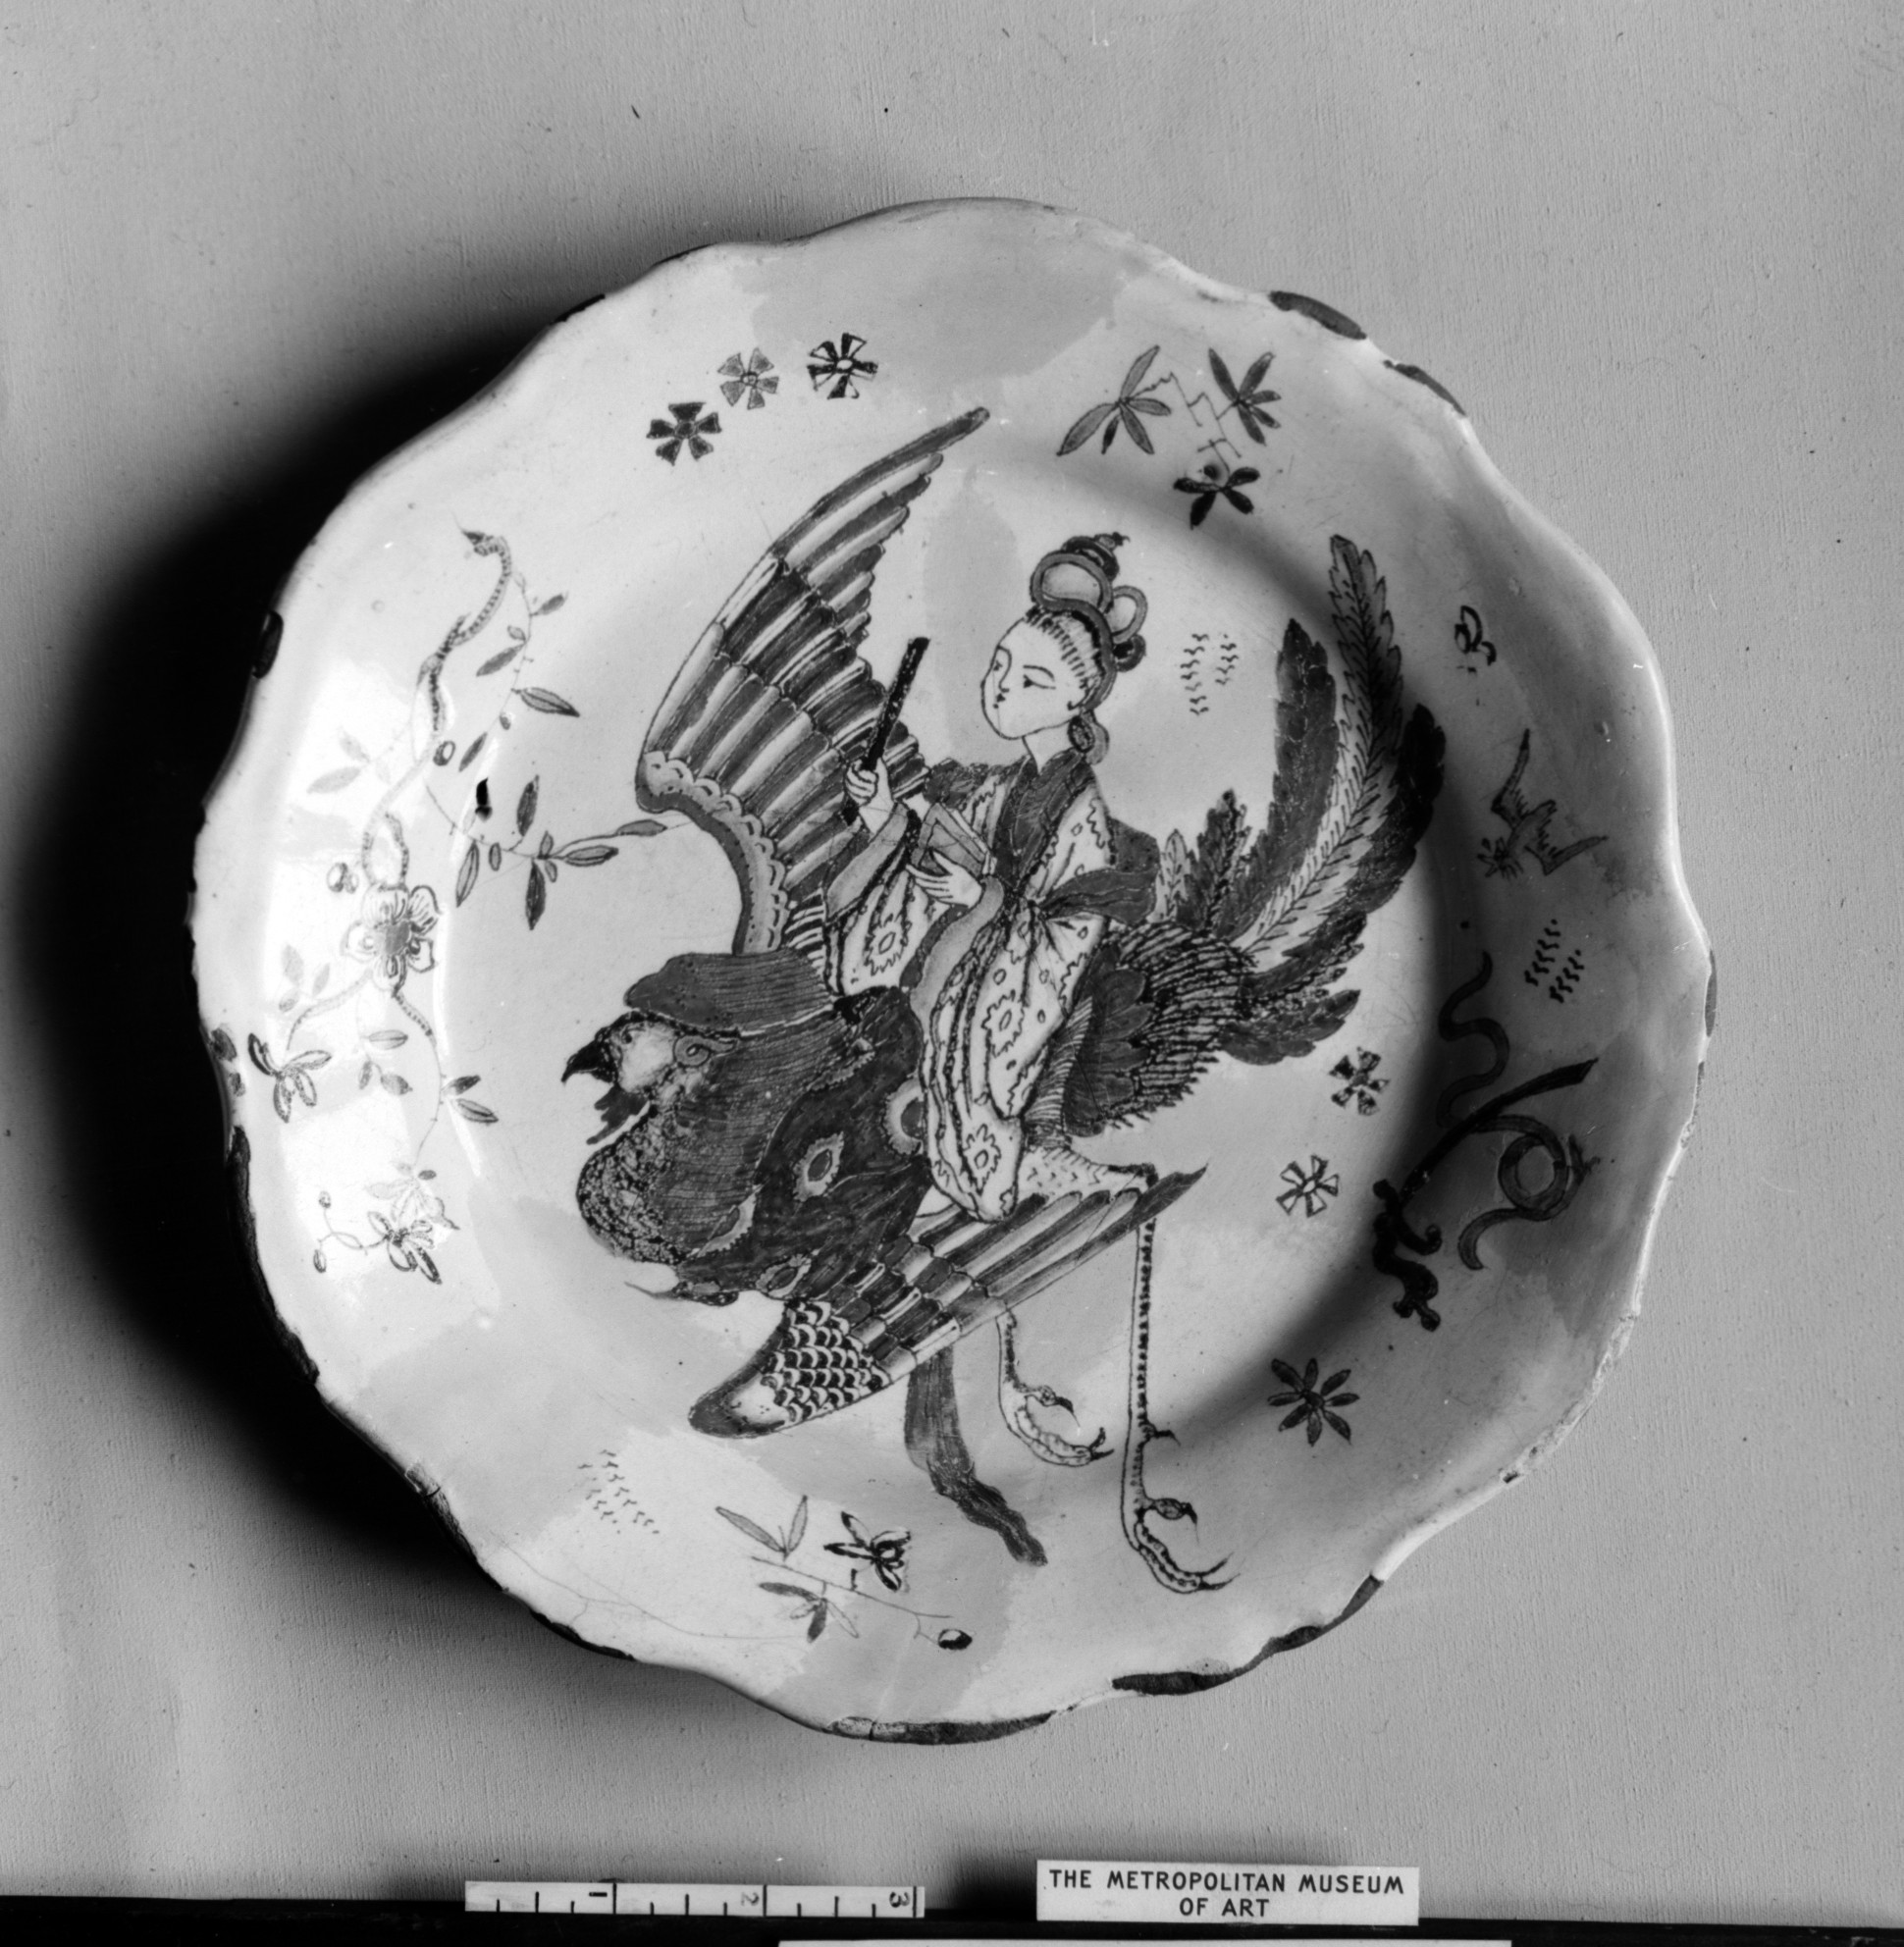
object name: plate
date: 1701-1800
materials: faience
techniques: glazing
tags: birds,women